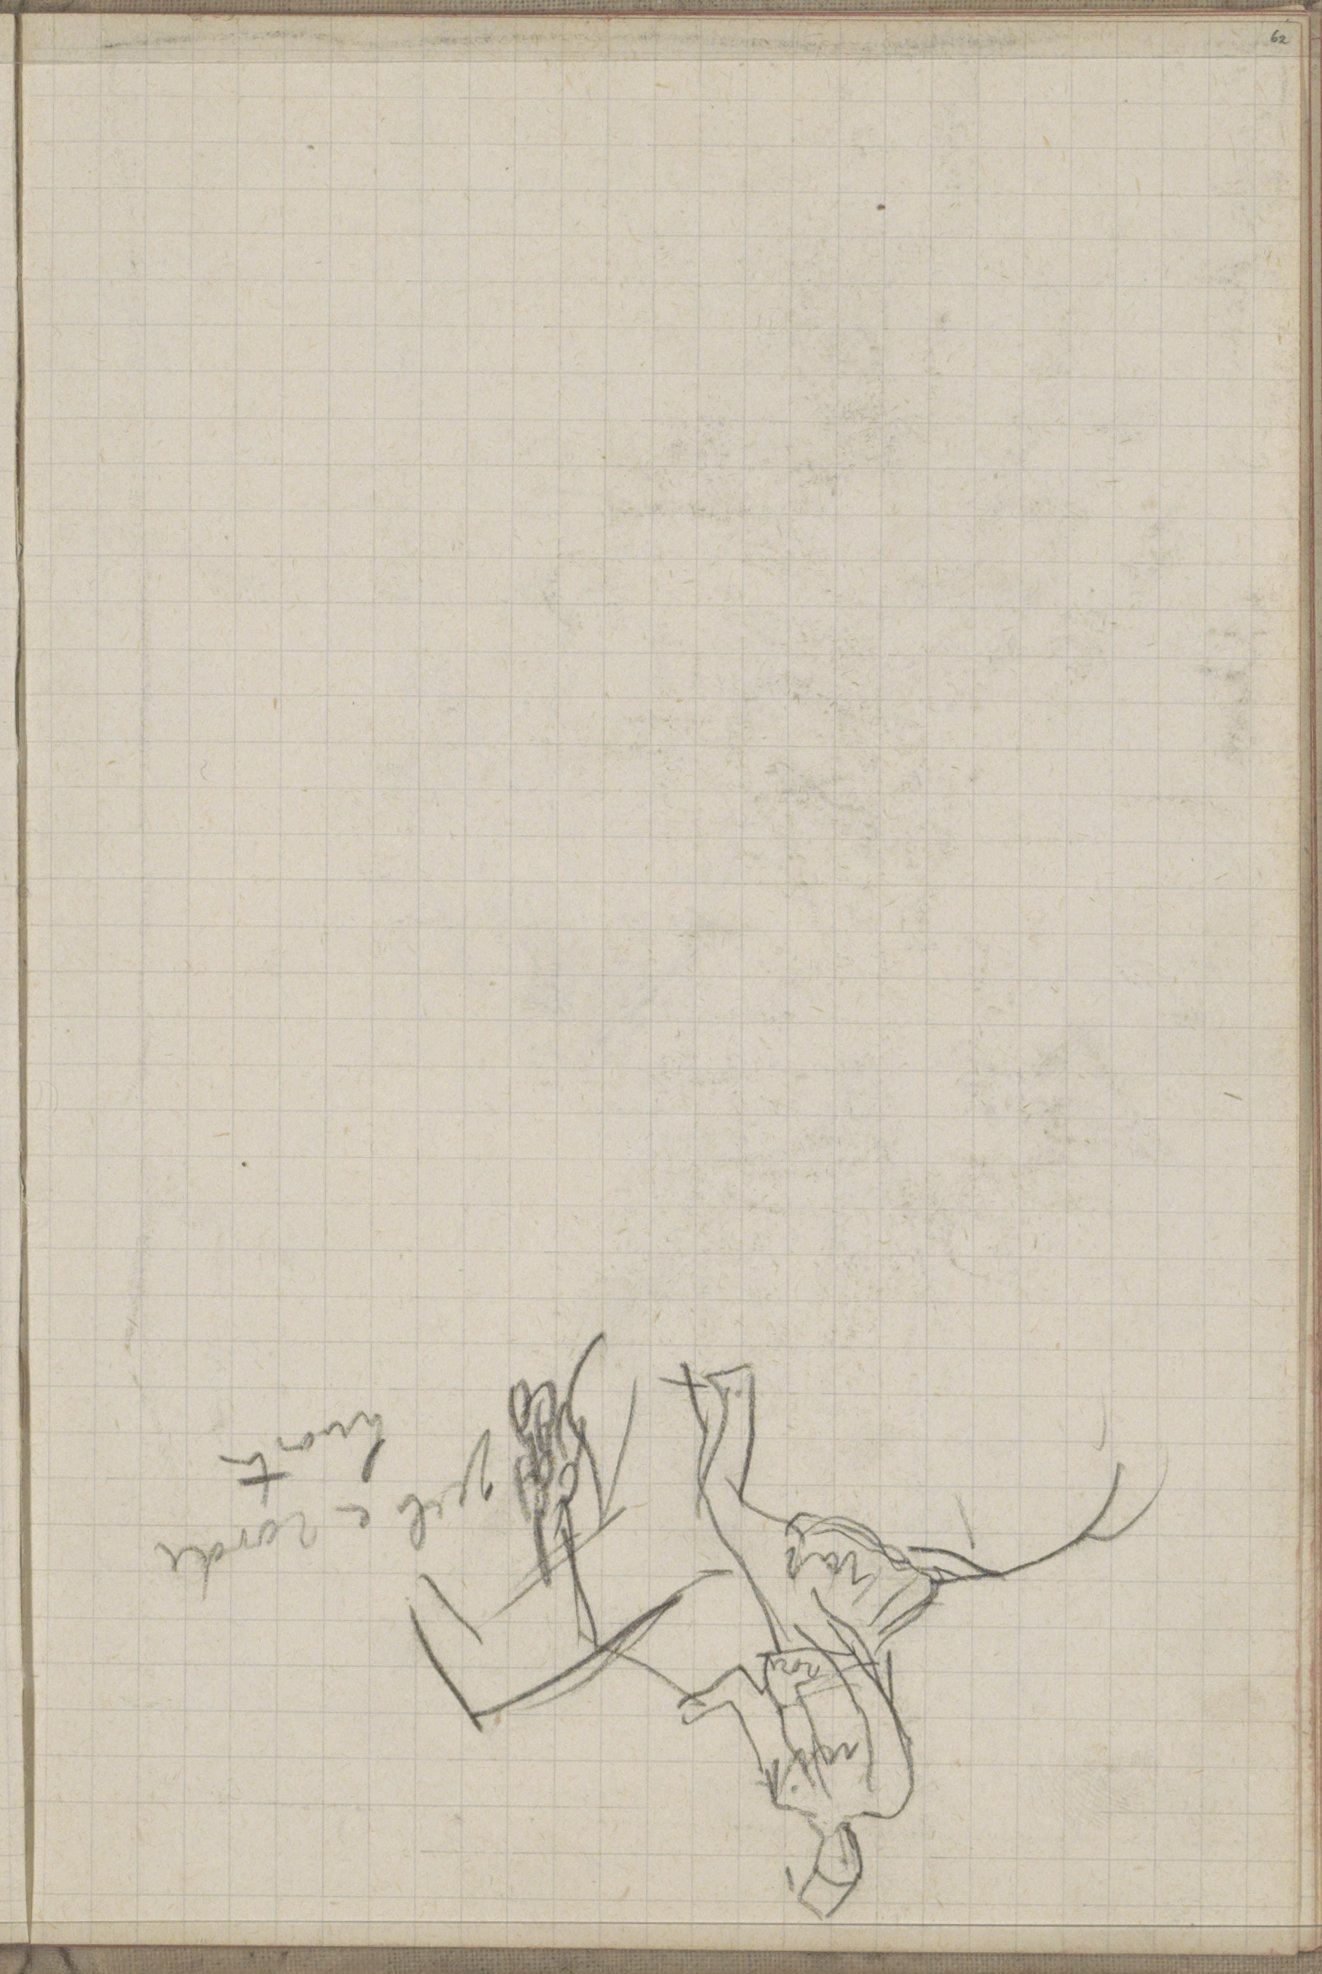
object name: sketchbook leaf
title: Ruiter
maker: marius bauer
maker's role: draughtsman, print maker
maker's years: 1867-1932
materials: chalk, paper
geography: istanbul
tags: riding a horse, ass, or mule; rider, horseman, asiatic races and peoples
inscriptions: kleurnotitie, handgeschreven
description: In oosterse kleding en met hoofddeksel. Pagina 62 uit een schetsboek met 51 bladen.